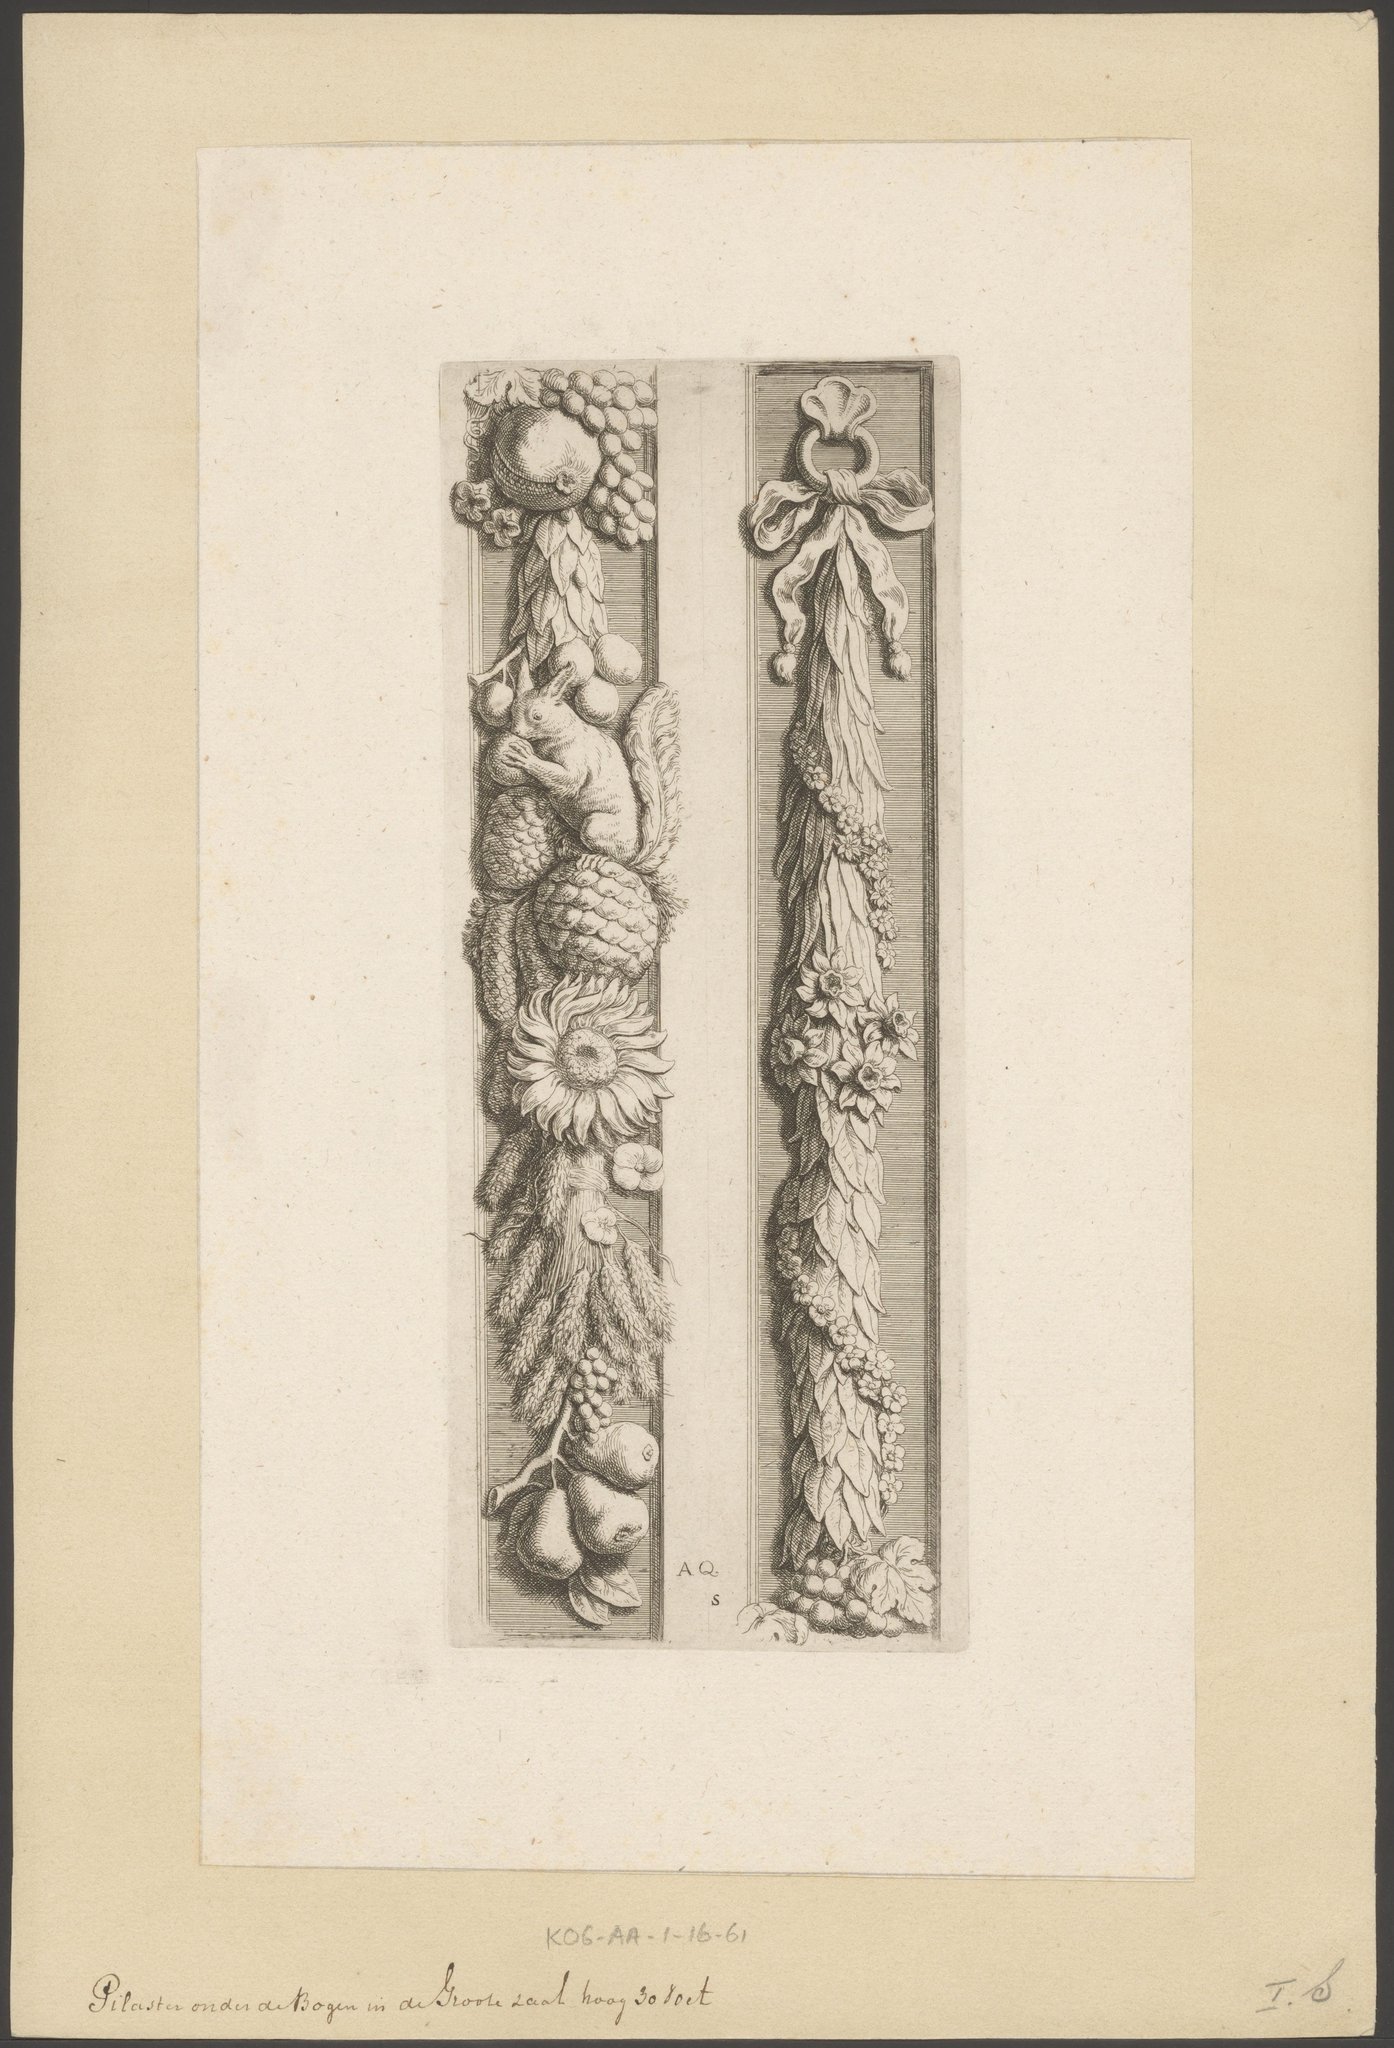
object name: print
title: Pilasterfestoen met eekhoorn, fruit, bloemen, bladeren en maïs tussen galerij en Burgerzaal in het Stadhuis op de Dam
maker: hubert quellinus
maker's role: print maker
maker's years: 1619-1687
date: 1655-1665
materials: paper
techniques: engraving, etching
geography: amsterdam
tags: fruits: pine-cone, fruits and vegetables ~ ornament, townhall, ornament ~ festoon, garland, rodents: squirrel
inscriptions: collector's mark: ‘16,61’ Lugt 1641b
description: Prent gebruikt in: Prima pars. Praecipuarum effigierum ac ornamentorum, amplissimae Curiae Amstelrodamensis (…) / Het eerste deel. Van de voornaemste Statuen ende Ciraten, vant konstijck Stadhuys van Amstelredam, tmeeste in marmer gemaeckt, door Artus Quellinus, Beelthouwer der voorseyde Stadt / La Premier Partie. De plusieurs Figures et ornements, de la Maison de Ville d'Amsterdam (…). Amsterdam: Artus Quellinus (I), 1655. Zie RP-P-AO-22-1-1 voor bijhorende titelpagina. Zie RP-P-AO-22-1-2 voor bijhorend register. Zie RP-P-AO-22-1A, RP-P-AO-22-1B, RP-P-AO-22-1C, RP-P-AO-22-1D-1, RP-P-AO-22-1D-2, RP-P-AO-22-1E, RP-P-AO-22-1F, RP-P-AO-22-1G, RP-P-AO-22-1H, RP-P-AO-22-1I, RP-P-AO-22-1K-1, RP-P-AO-22-1K-2, RP-P-AO-22-1K-3, RP-P-AO-22-1K-4, RP-P-AO-22-1K-5, RP-P-AO-22-1L-1, RP-P-AO-22-1L-2, RP-P-AO-22-1M-1, RP-P-AO-22-1M-2, RP-P-AO-22-1N-1, RP-P-AO-22-1N-2, RP-P-AO-22-1N-3, RP-P-AO-22-1N-4, RP-P-AO-22-1N-5, RP-P-AO-22-1O-1, RP-P-AO-22-1O-2, RP-P-AO-22-1O-3, RP-P-AO-22-1O-4, RP-P-AO-22-1P-1, RP-P-AO-22-1P-2, RP-P-AO-22-1P-3, RP-P-AO-22-1P-4, RP-P-AO-22-1Q-1, RP-P-AO-22-1Q-2, RP-P-AO-22-1Q-3, RP-P-AO-22-1Q-4, RP-P-AO-22-1R-1, RP-P-AO-22-1R-2, RP-P-AO-22-1R-3, RP-P-AO-22-1R-4, RP-P-AO-22-1R-5, RP-P-AO-22-1S-1, RP-P-AO-22-1S-2, RP-P-AO-22-1S-3, RP-P-AO-22-1S-5, RP-P-AO-22-1T-1 en RP-P-AO-22-1T-2 voor andere prenten uit deze publicatie. Zelfde staat van prent ook gebruikt in: Prima pars. Praecipuarum effigierum ac ornamentorum, amplissimae Curiae Amstelrodamensis (…) / Het eerste deel. Van de voornaemste Statuen ende Ciraten, vant konstijck Stadhuys van Amstelredam, tmeeste in marmer gemaeckt, door Artus Quellinus, Beelthouwer der voorseyde Stadt / La Premier Partie. De plusieurs Figures et ornements, de la Maison de Ville d'Amsterdam (…). Amsterdam: Frederik de Wit, 1665. Latere staat van prent ook gebruikt in: Architecture peinture et sculpture de la Maison de Ville d'Amsterdam, representee en CIX. figures en taille-douce (…). Amsterdam: David Mortier, 1719. En in: Architecture peinture et sculpture de la Maison de Ville d'Amsterdam, representee en CIX. figures en taille-douce (…). Amsterdam: Gerard Valck, 1719. En in: Bouw schilder en beeldhouwkonst, van het Stadhuis te Amsteldam, vertoont in CIX figuuren (…). Amsterdam: Covens & Mortier & Covens Jr., s.a. (1774-1783).